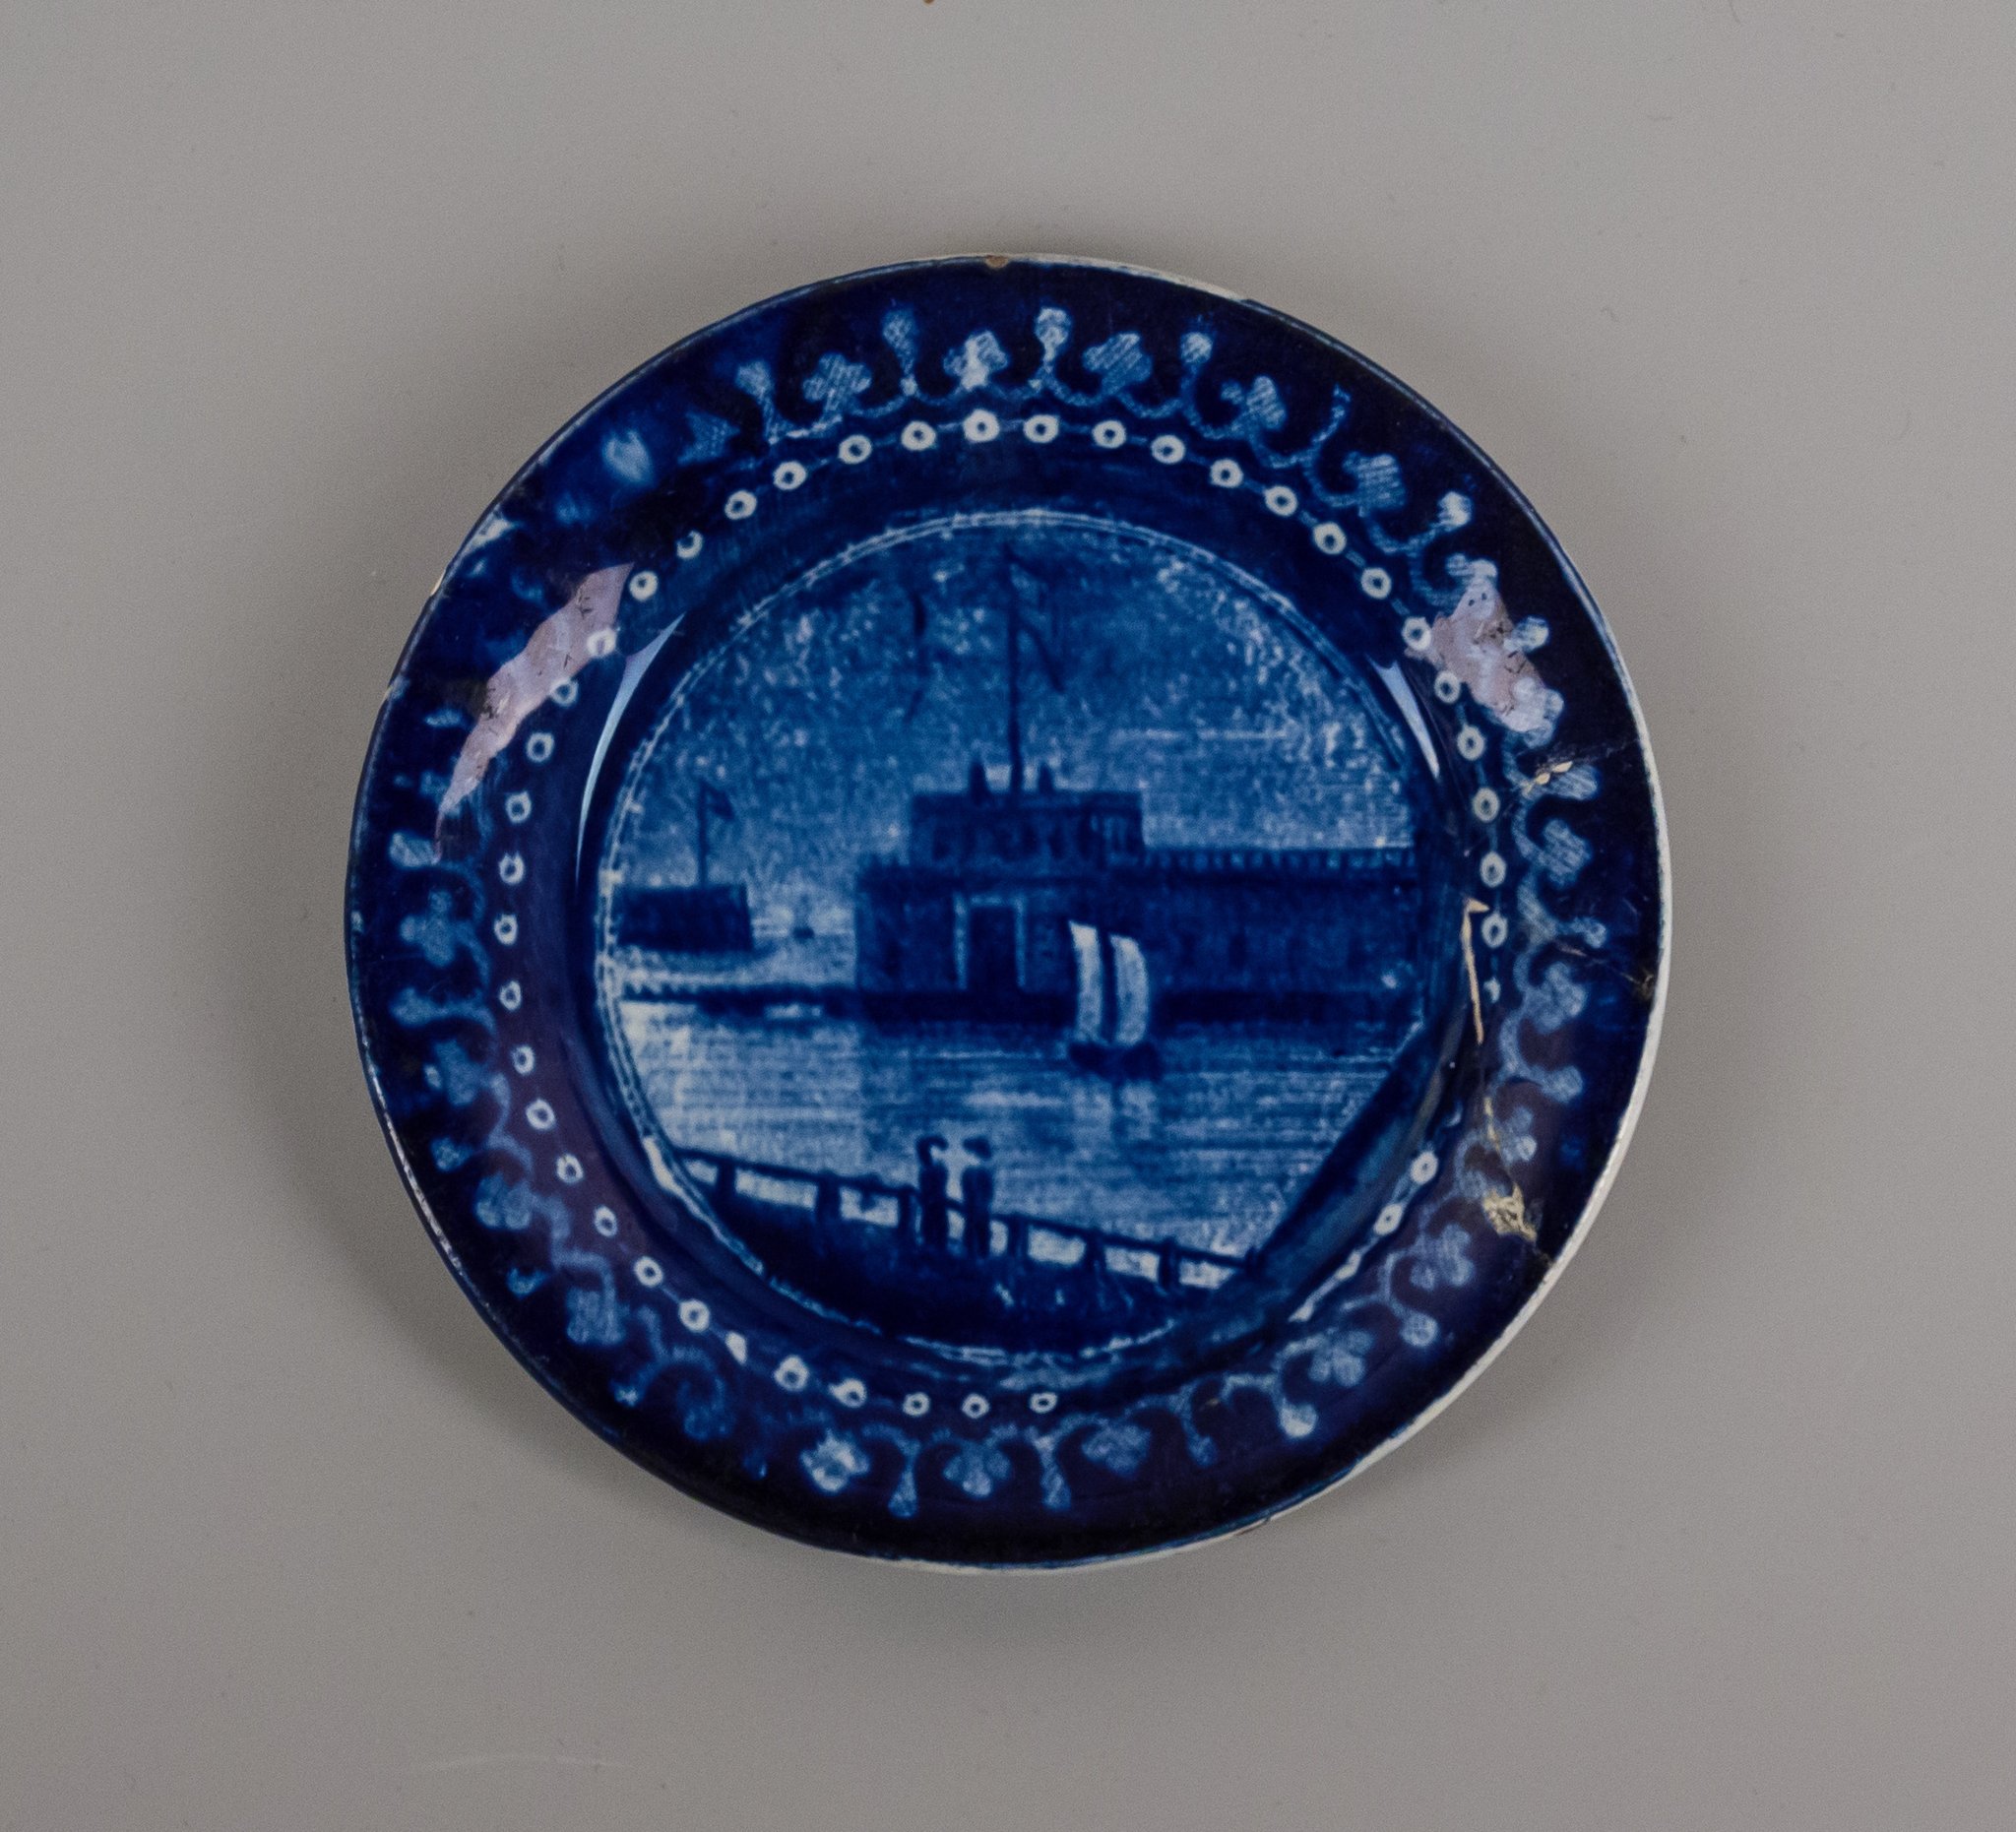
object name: cup plate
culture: british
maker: enoch wood & sons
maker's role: maker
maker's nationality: british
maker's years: 1818-1846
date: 1841-1846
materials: earthenware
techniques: transfer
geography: england